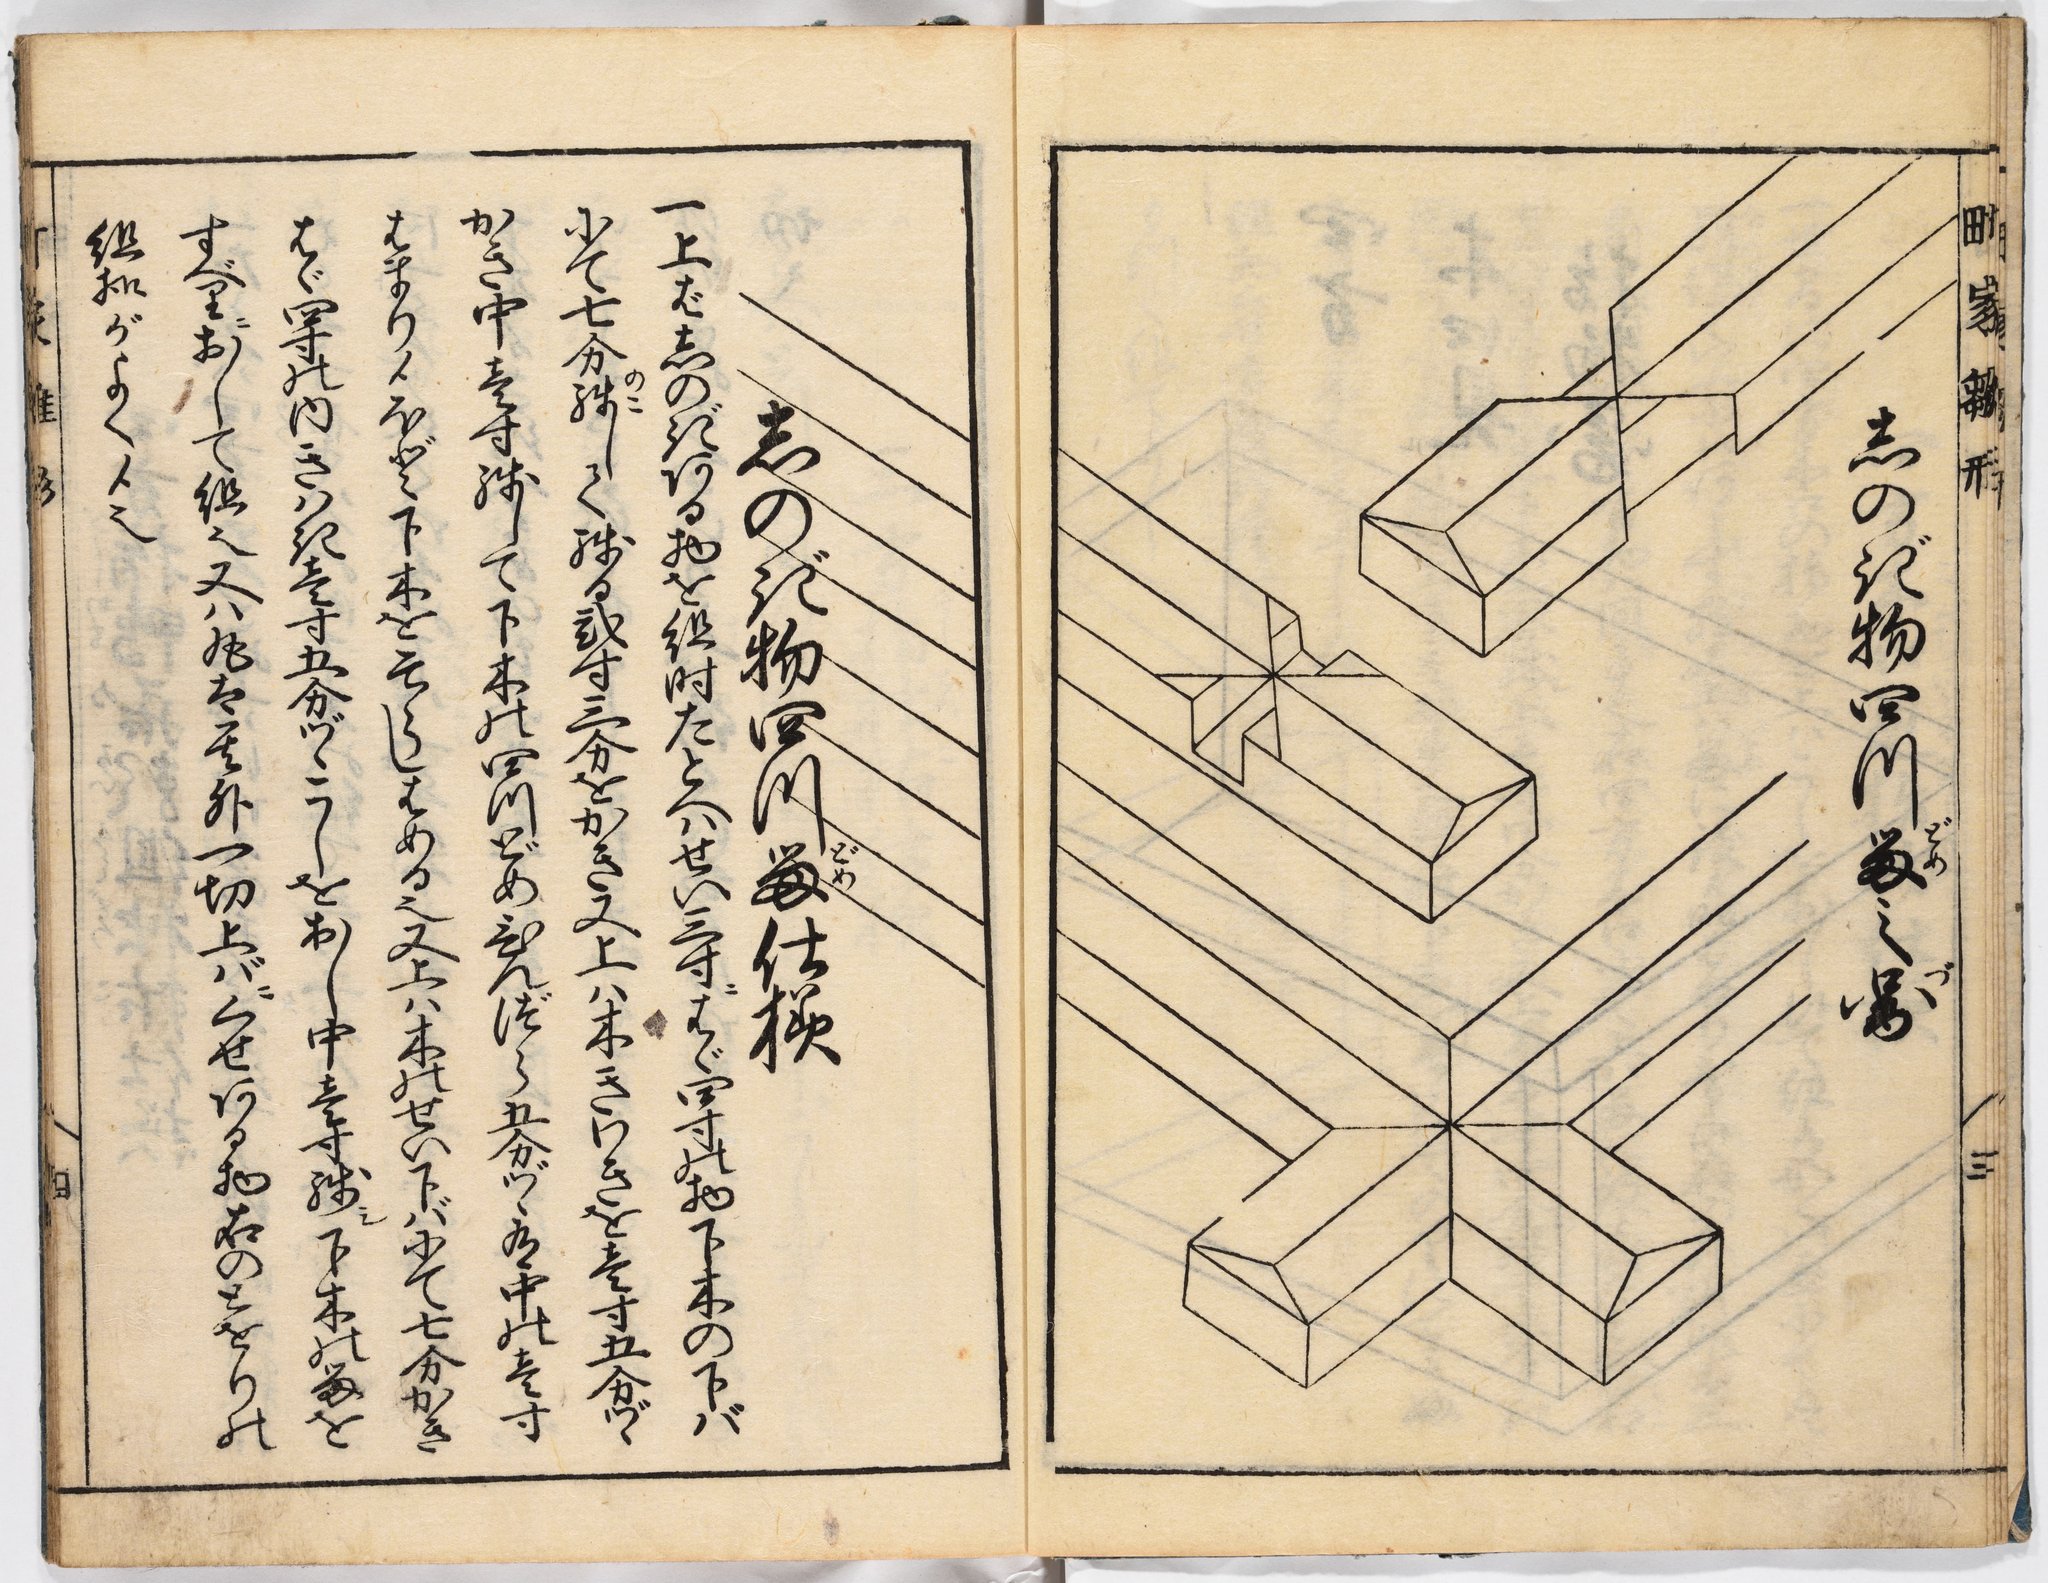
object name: illustrated book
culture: japanese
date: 1893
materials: ink, paper